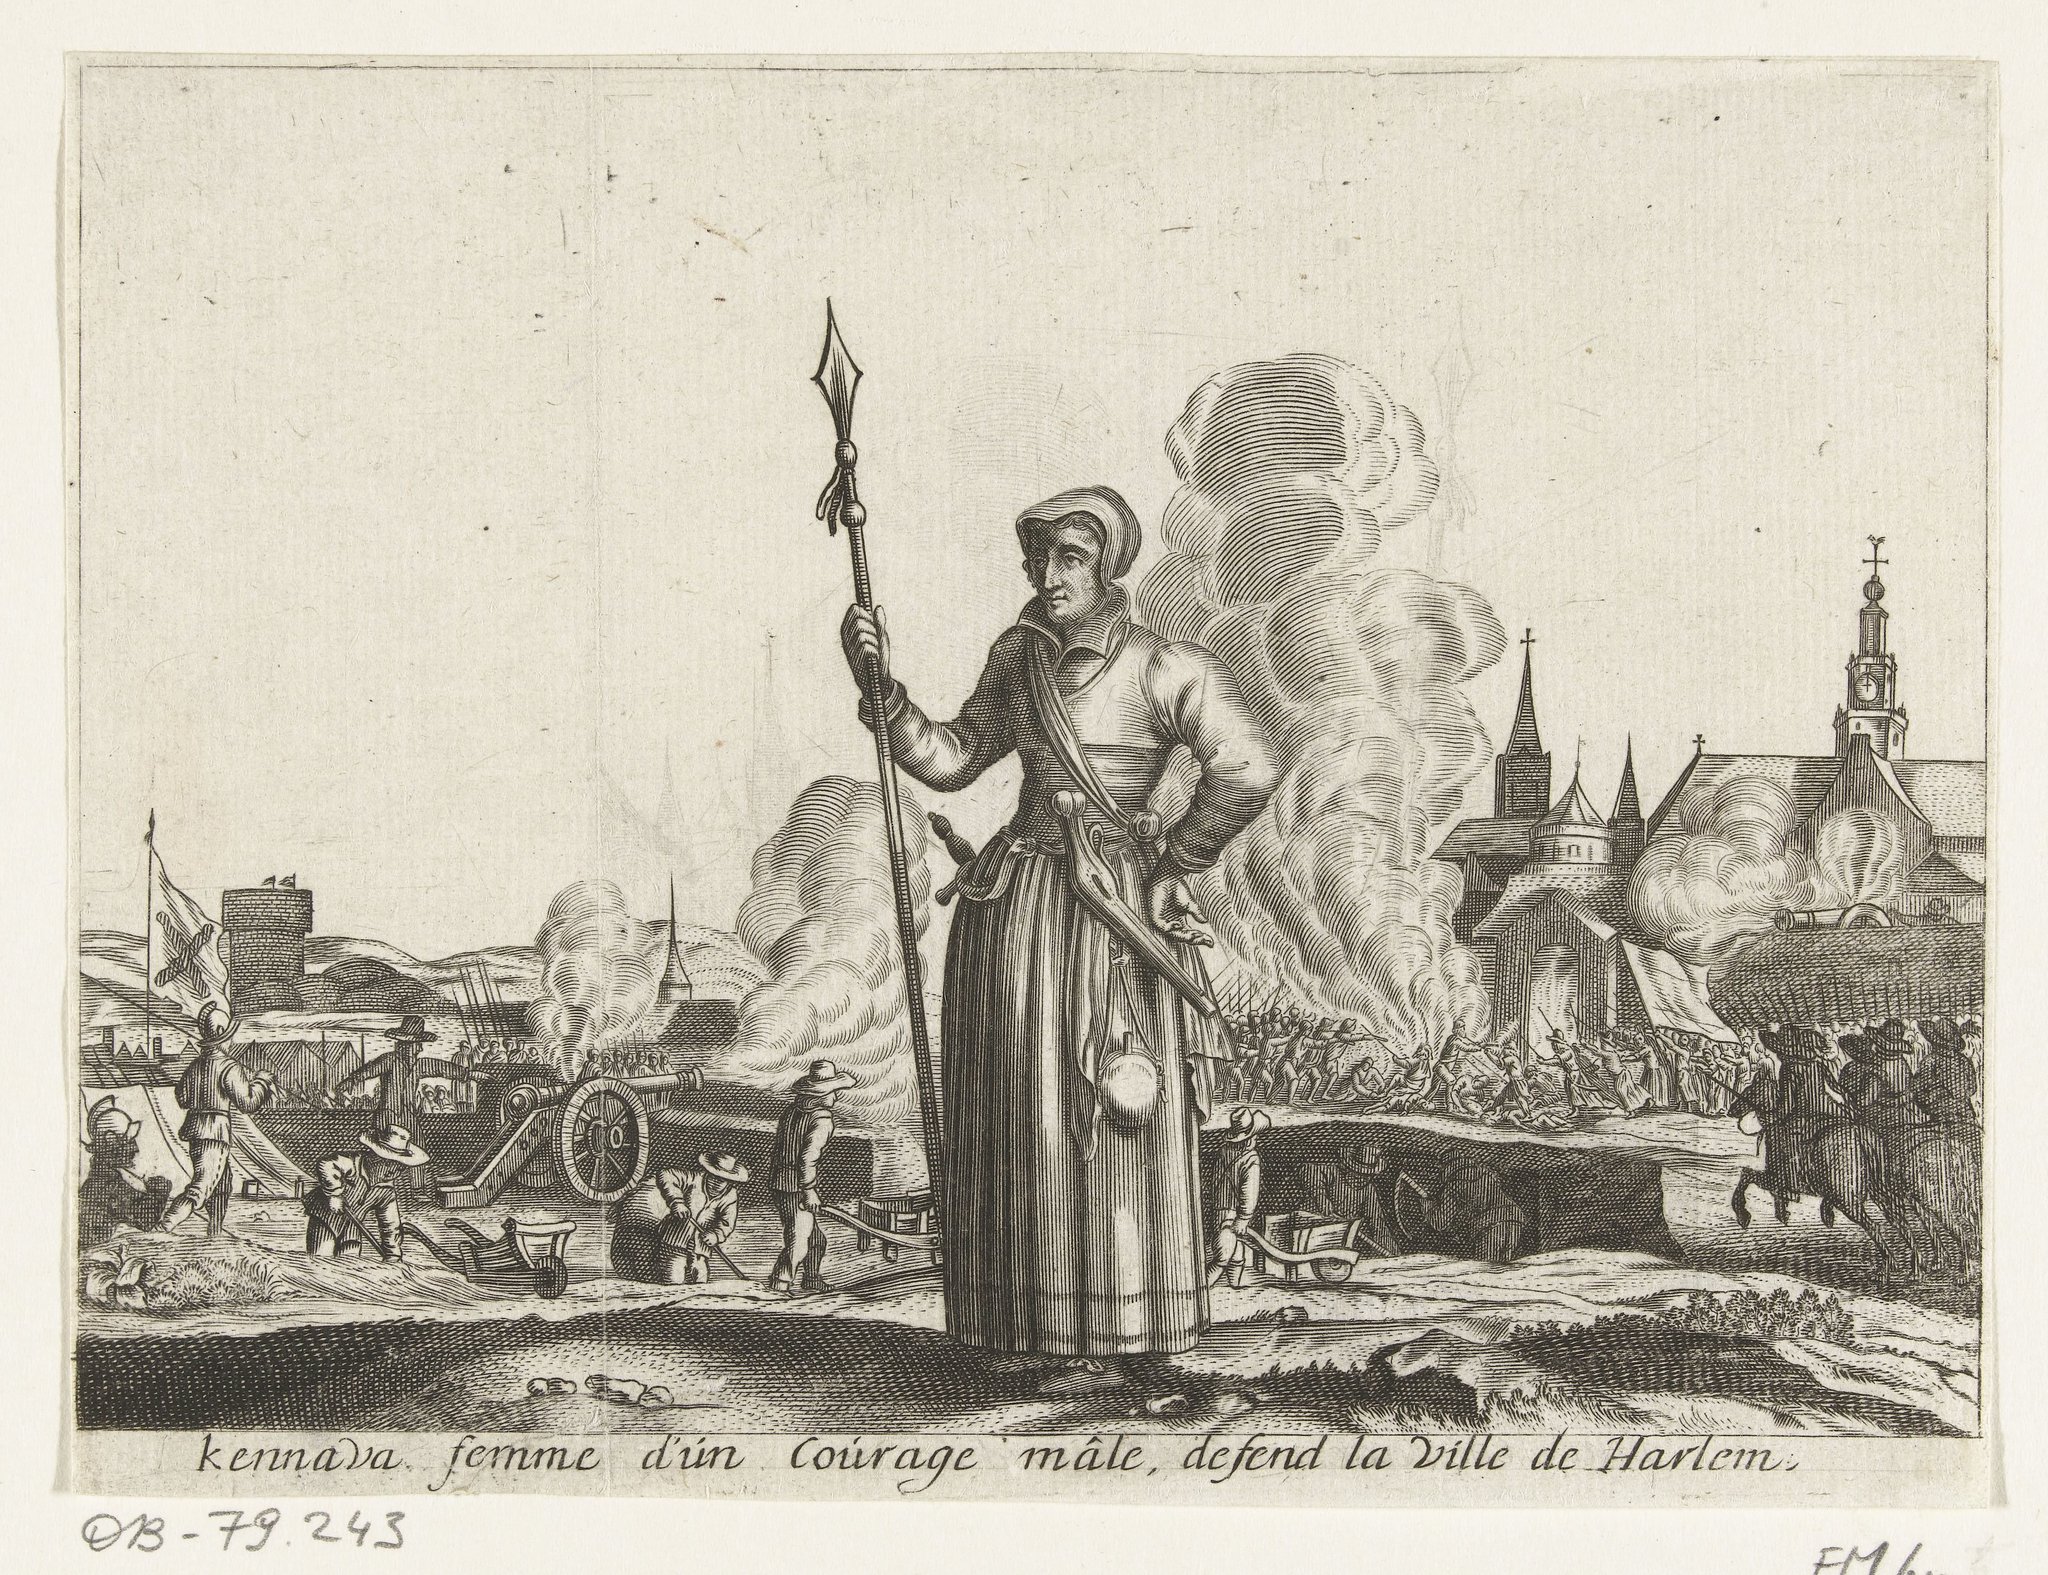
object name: print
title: Kenau met op de achtergrond het beleg van Haarlem, 1573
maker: lamberecht causé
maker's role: print maker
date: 1600-1699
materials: paper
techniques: engraving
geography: low countries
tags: siege, position war, haarlem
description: Kenau Simonsdochter Hasselaer, staande ten voeten uit met piek, op de achtergrond het beleg van Haarlem, 1573.